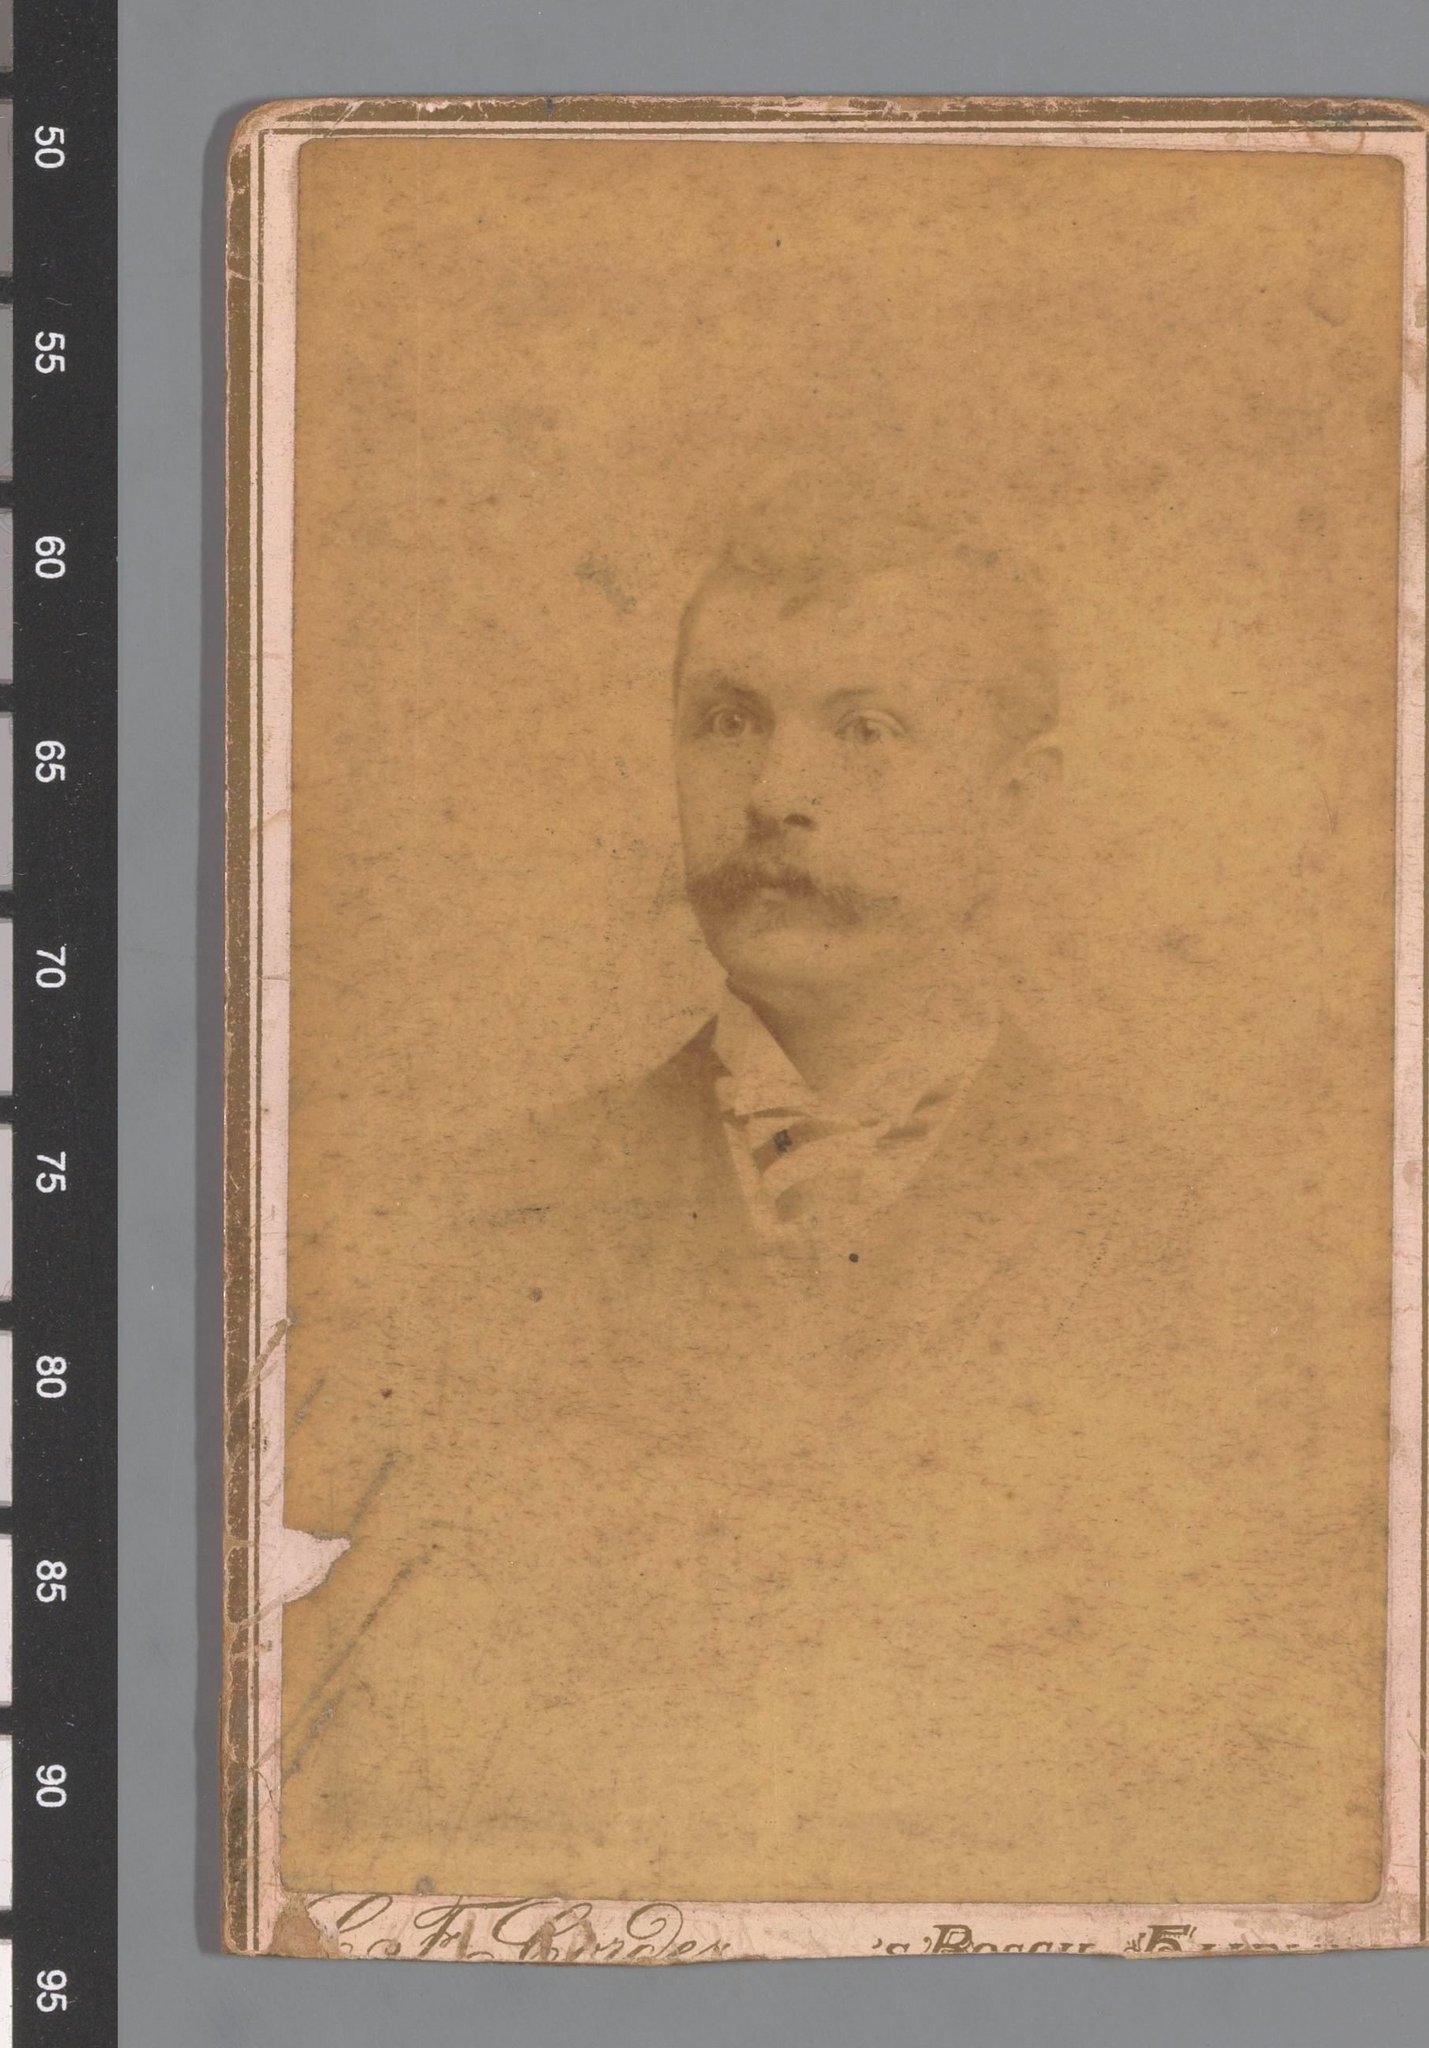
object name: photograph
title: Portret van een onbekende man met een snor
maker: carel frederik cordes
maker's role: fotograaf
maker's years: 1851-1927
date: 1882-1900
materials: cardboard, paper, photographic support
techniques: albumen print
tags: adult man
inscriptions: name: ‘Bijzondere inrichting voor vergrootingen in Kooldruk, Crayon, olieverf, en gewoone phot. Voor alle portretten [...] steeds nabesteld worden. C.F. Cordes 's Bosch aan de Parade Haarlem Groote Houtstraat. Op verschillende [...] bekroond en met [...]’, name: ‘C.F. Cordes [...]’